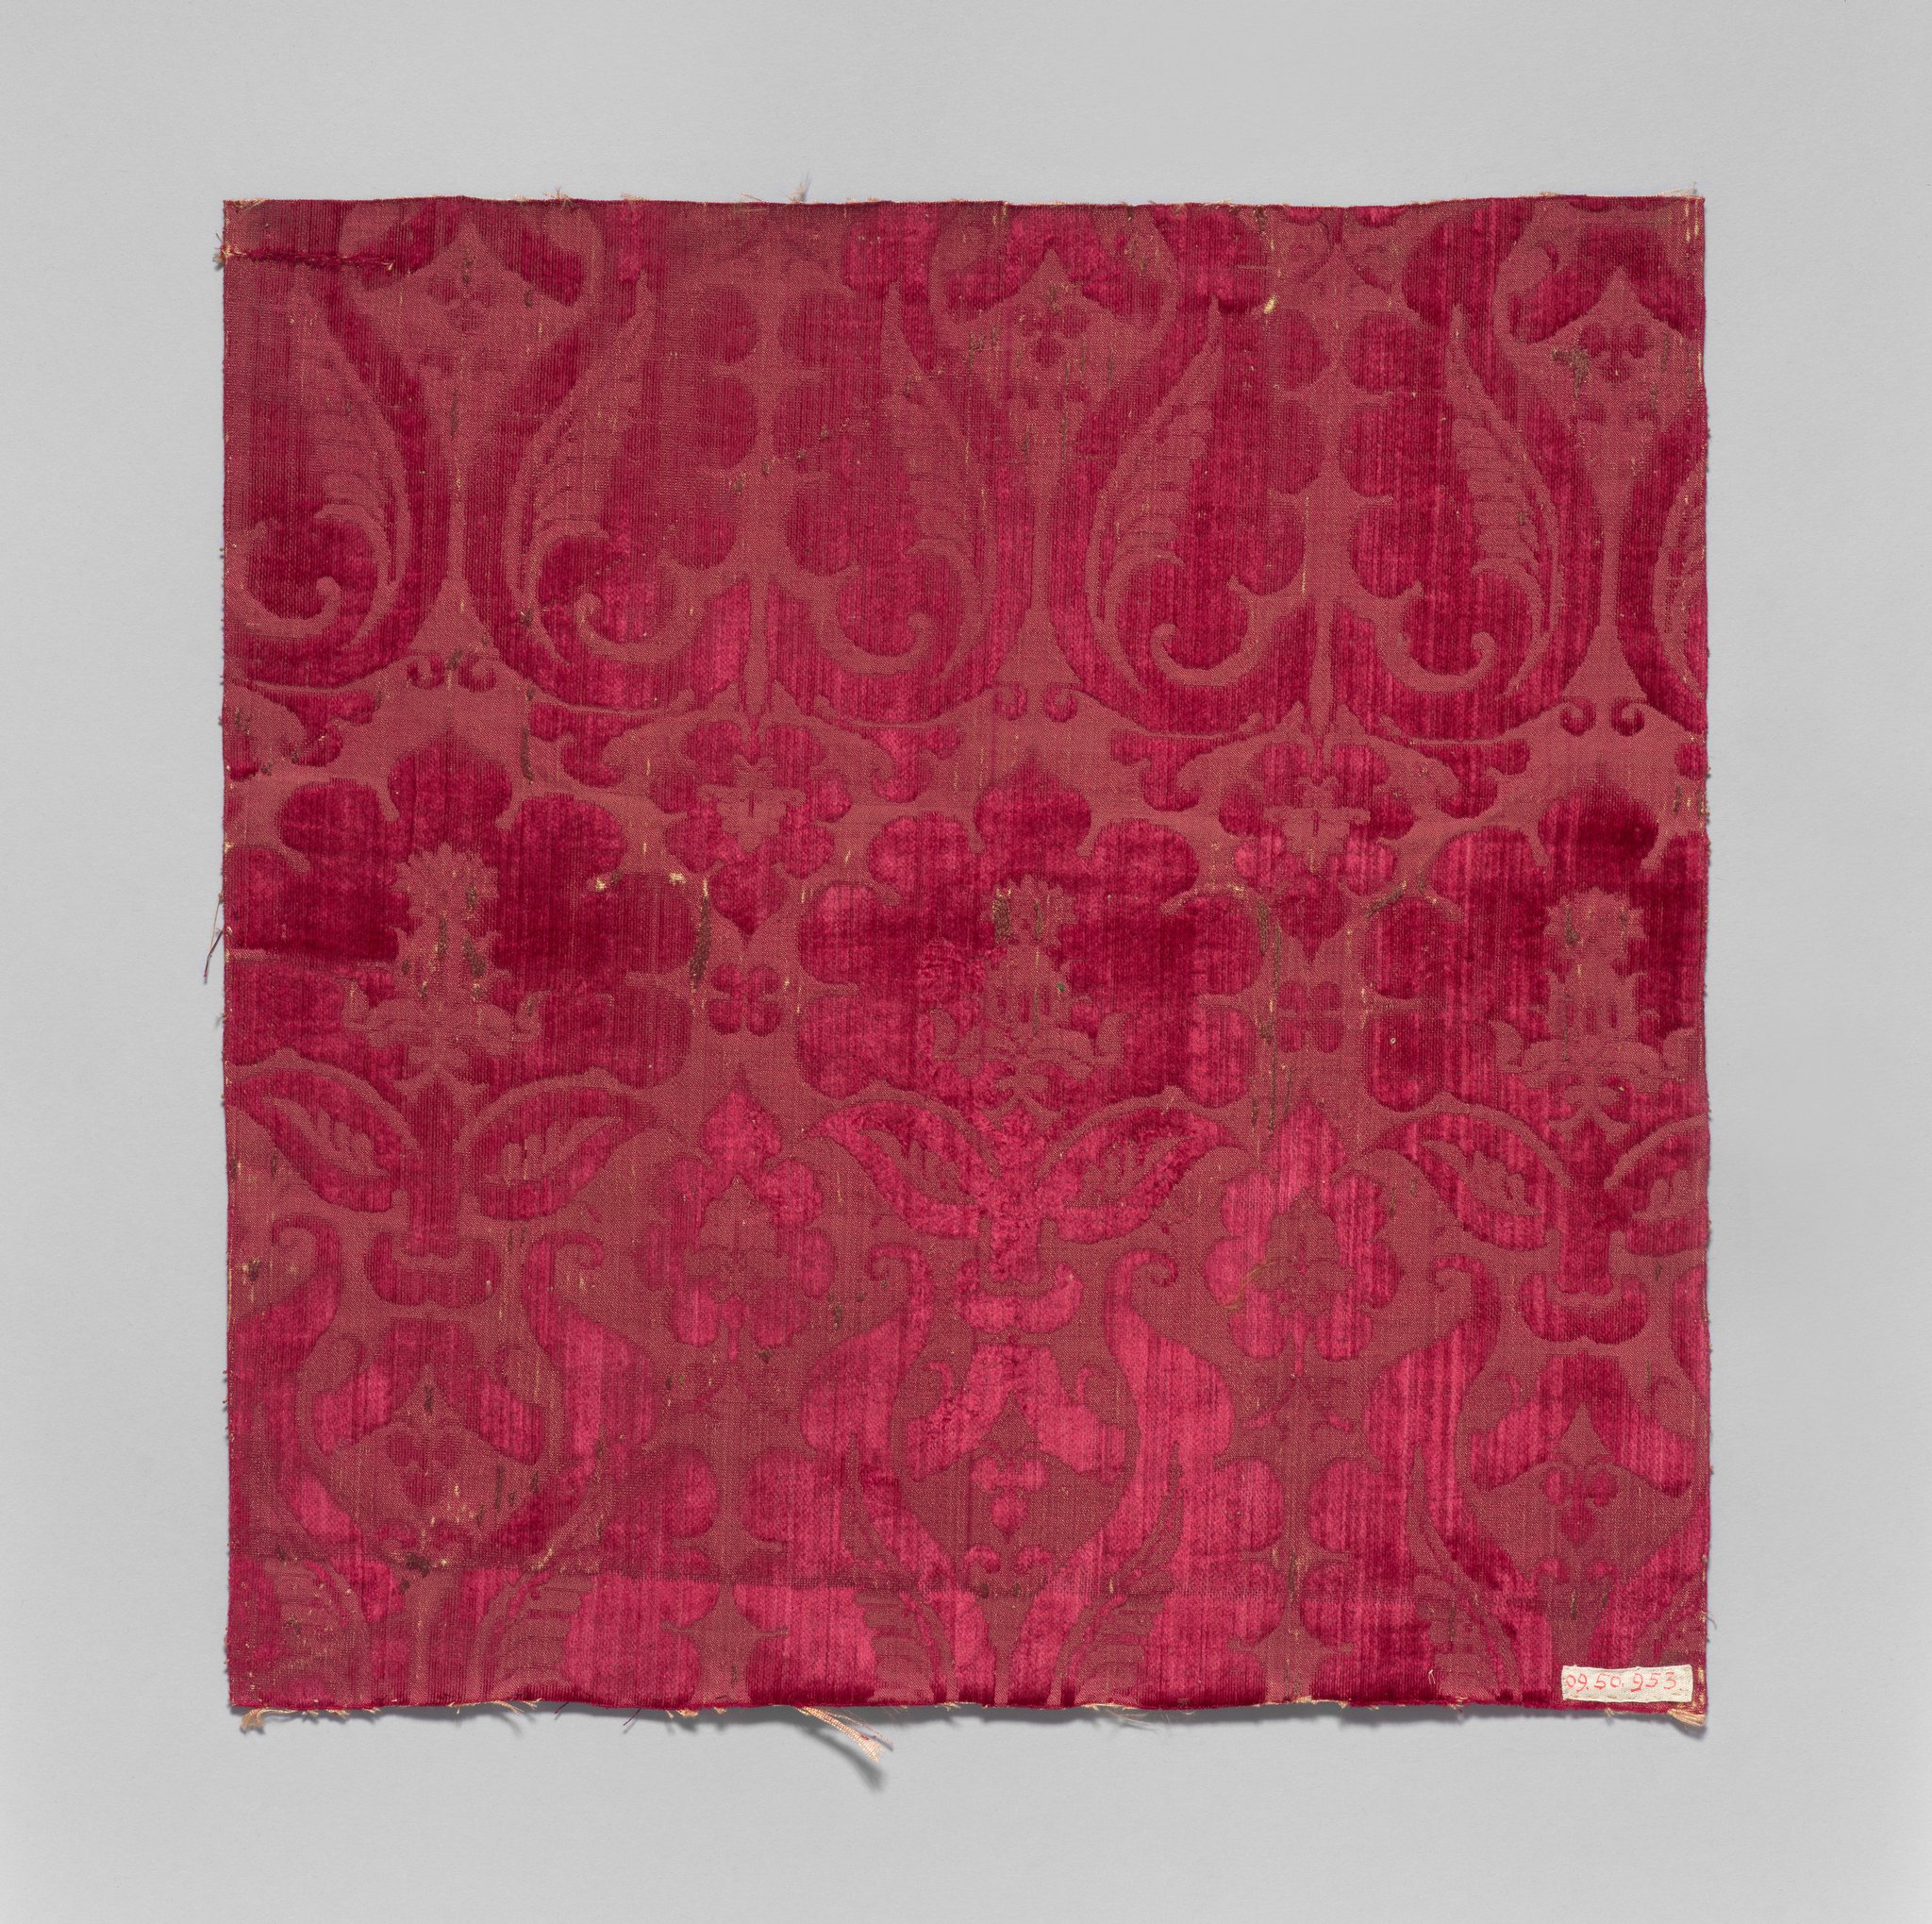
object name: piece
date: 1501-1600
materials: silk